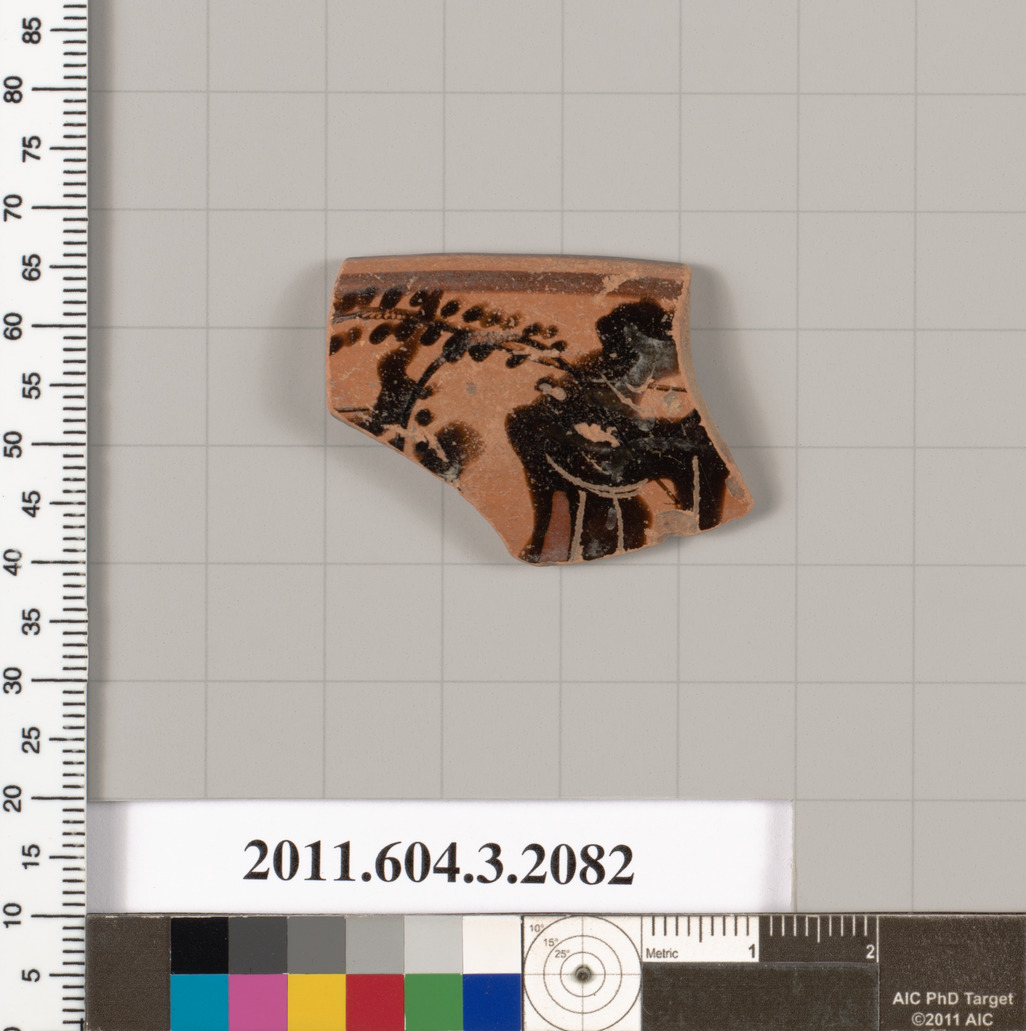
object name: kylix fragment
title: Terracotta rim fragment of a kylix (drinking cup)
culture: greek, attic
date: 500-480 BCE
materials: terracotta